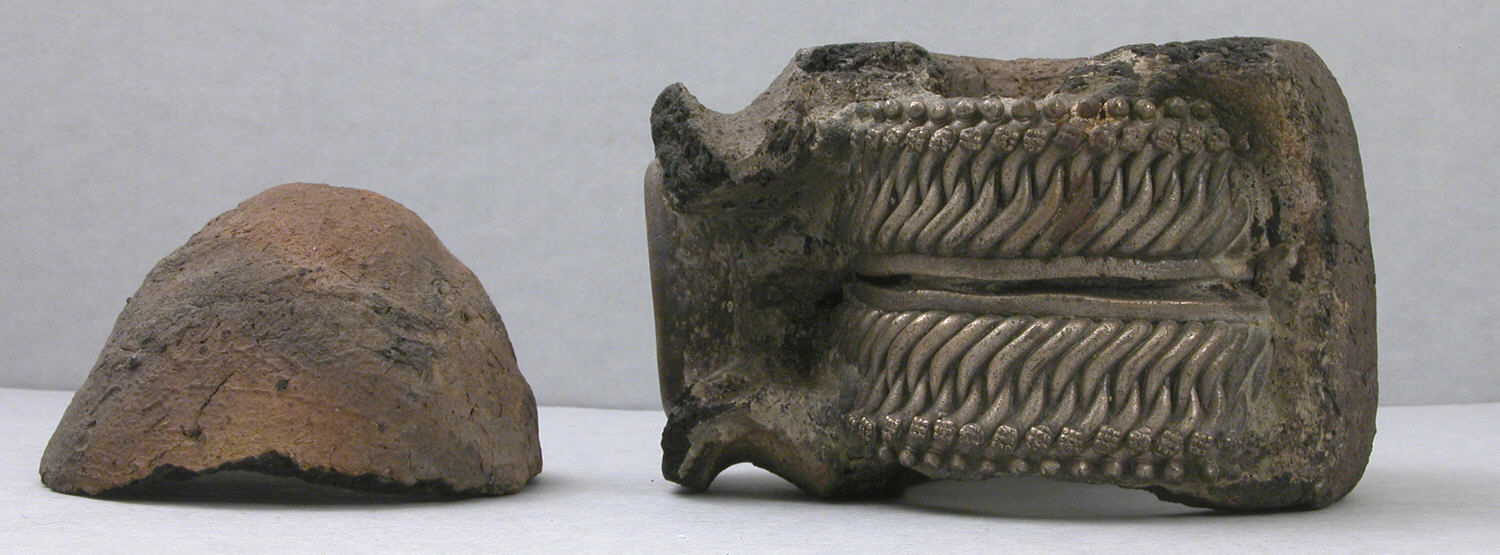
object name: jewelry mold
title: Mold for Jewelry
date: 1801-1900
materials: clay, metal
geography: india